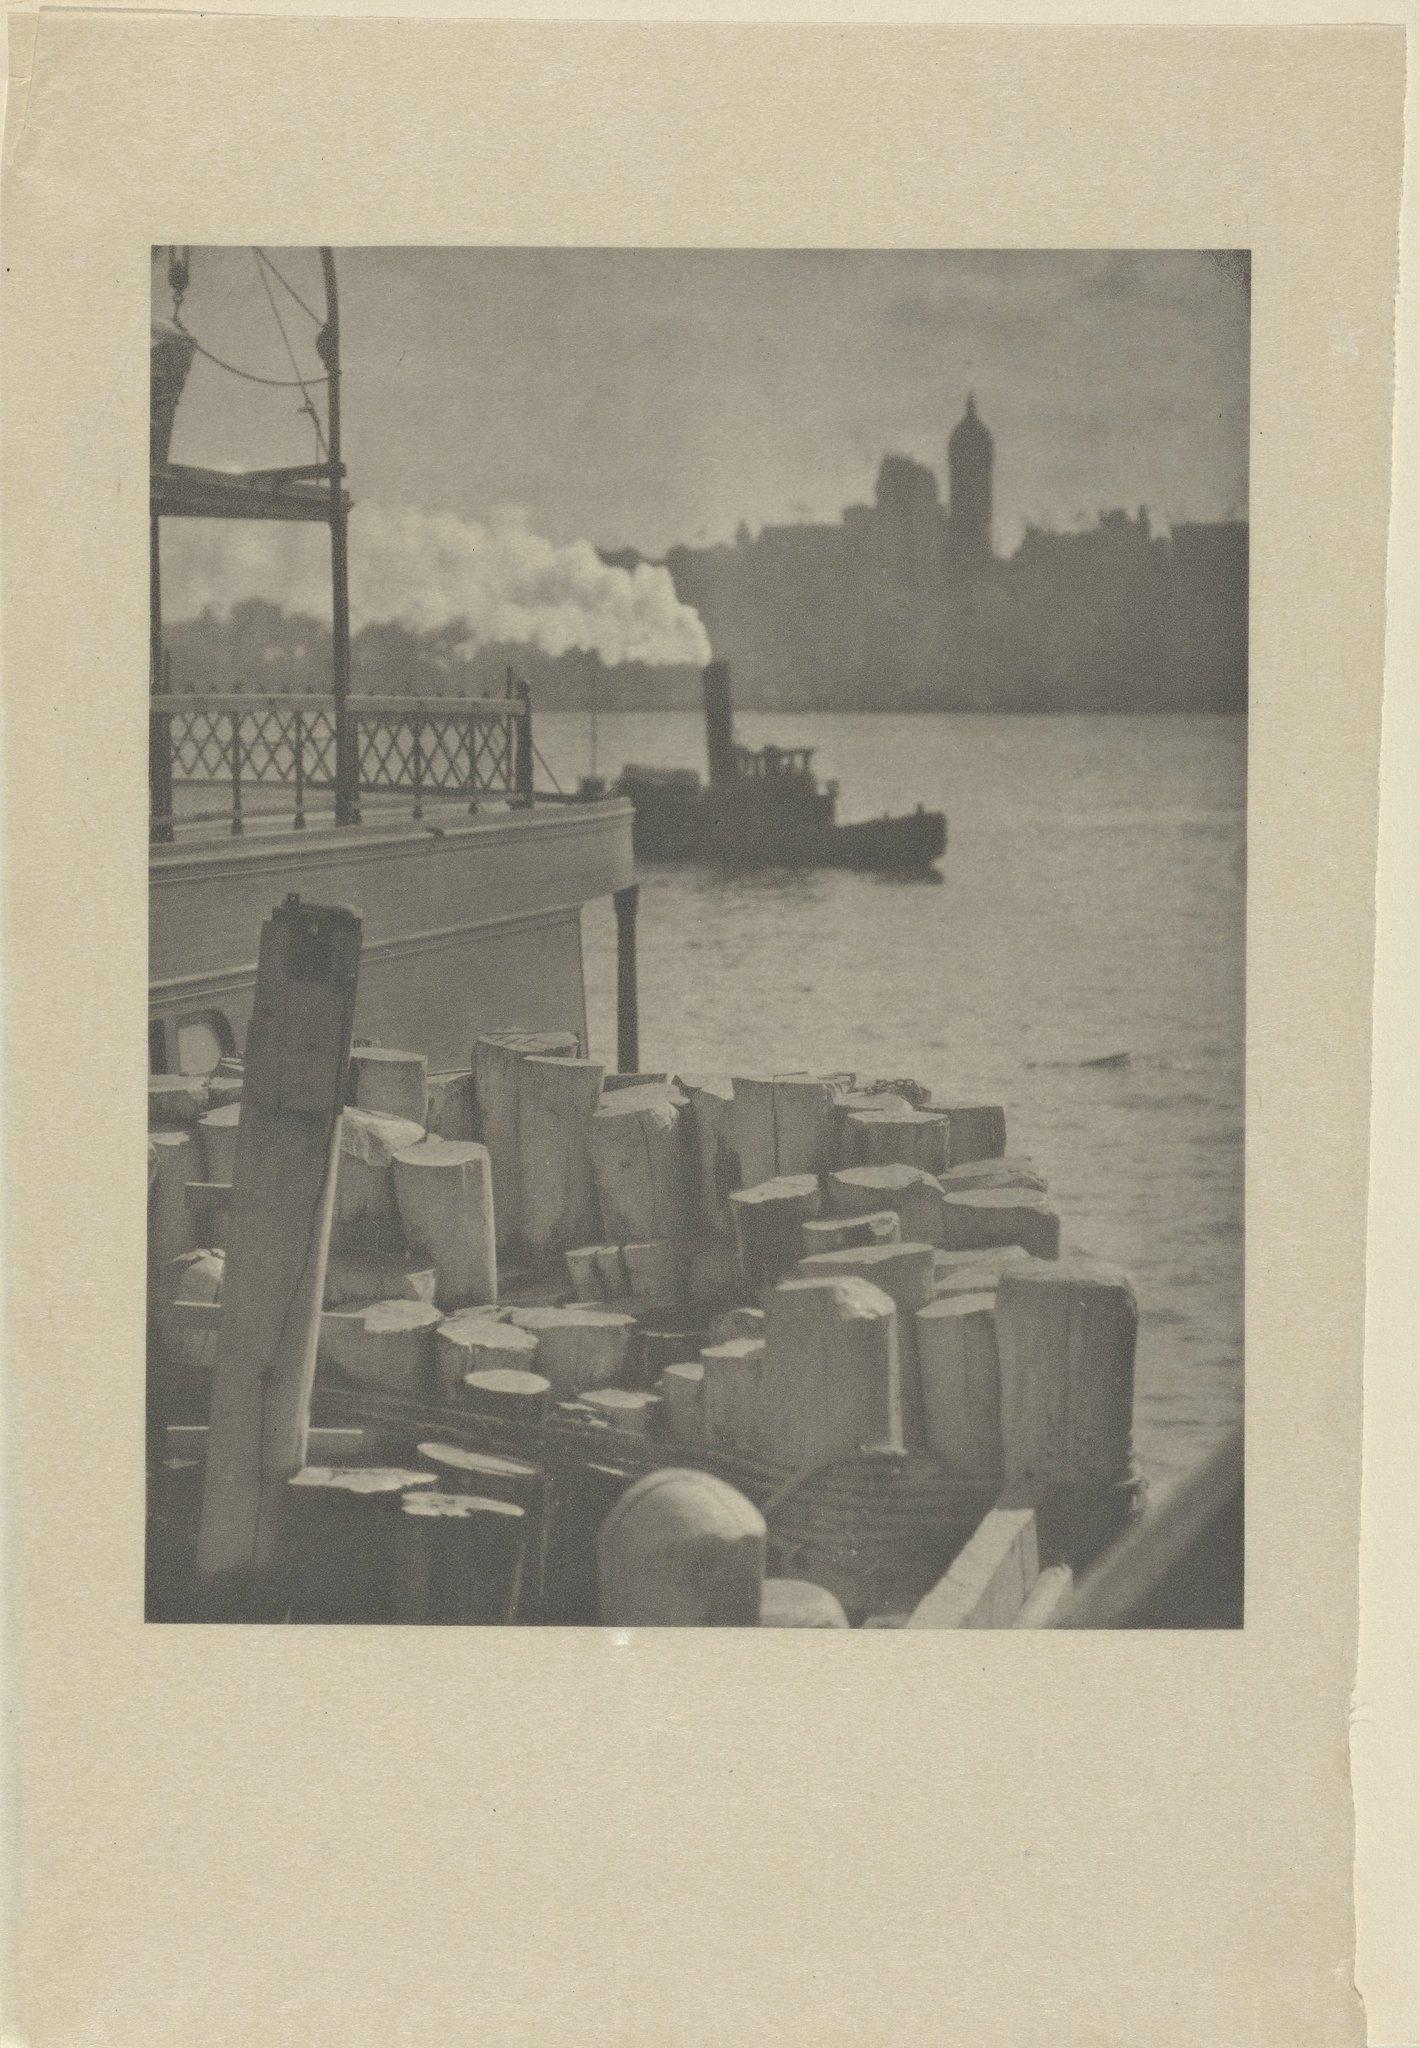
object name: photomechanical print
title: The City Across the River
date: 1910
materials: paper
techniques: photoaquatint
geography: new york city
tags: city-view in general; 'veduta'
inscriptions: number: ‘36:7’